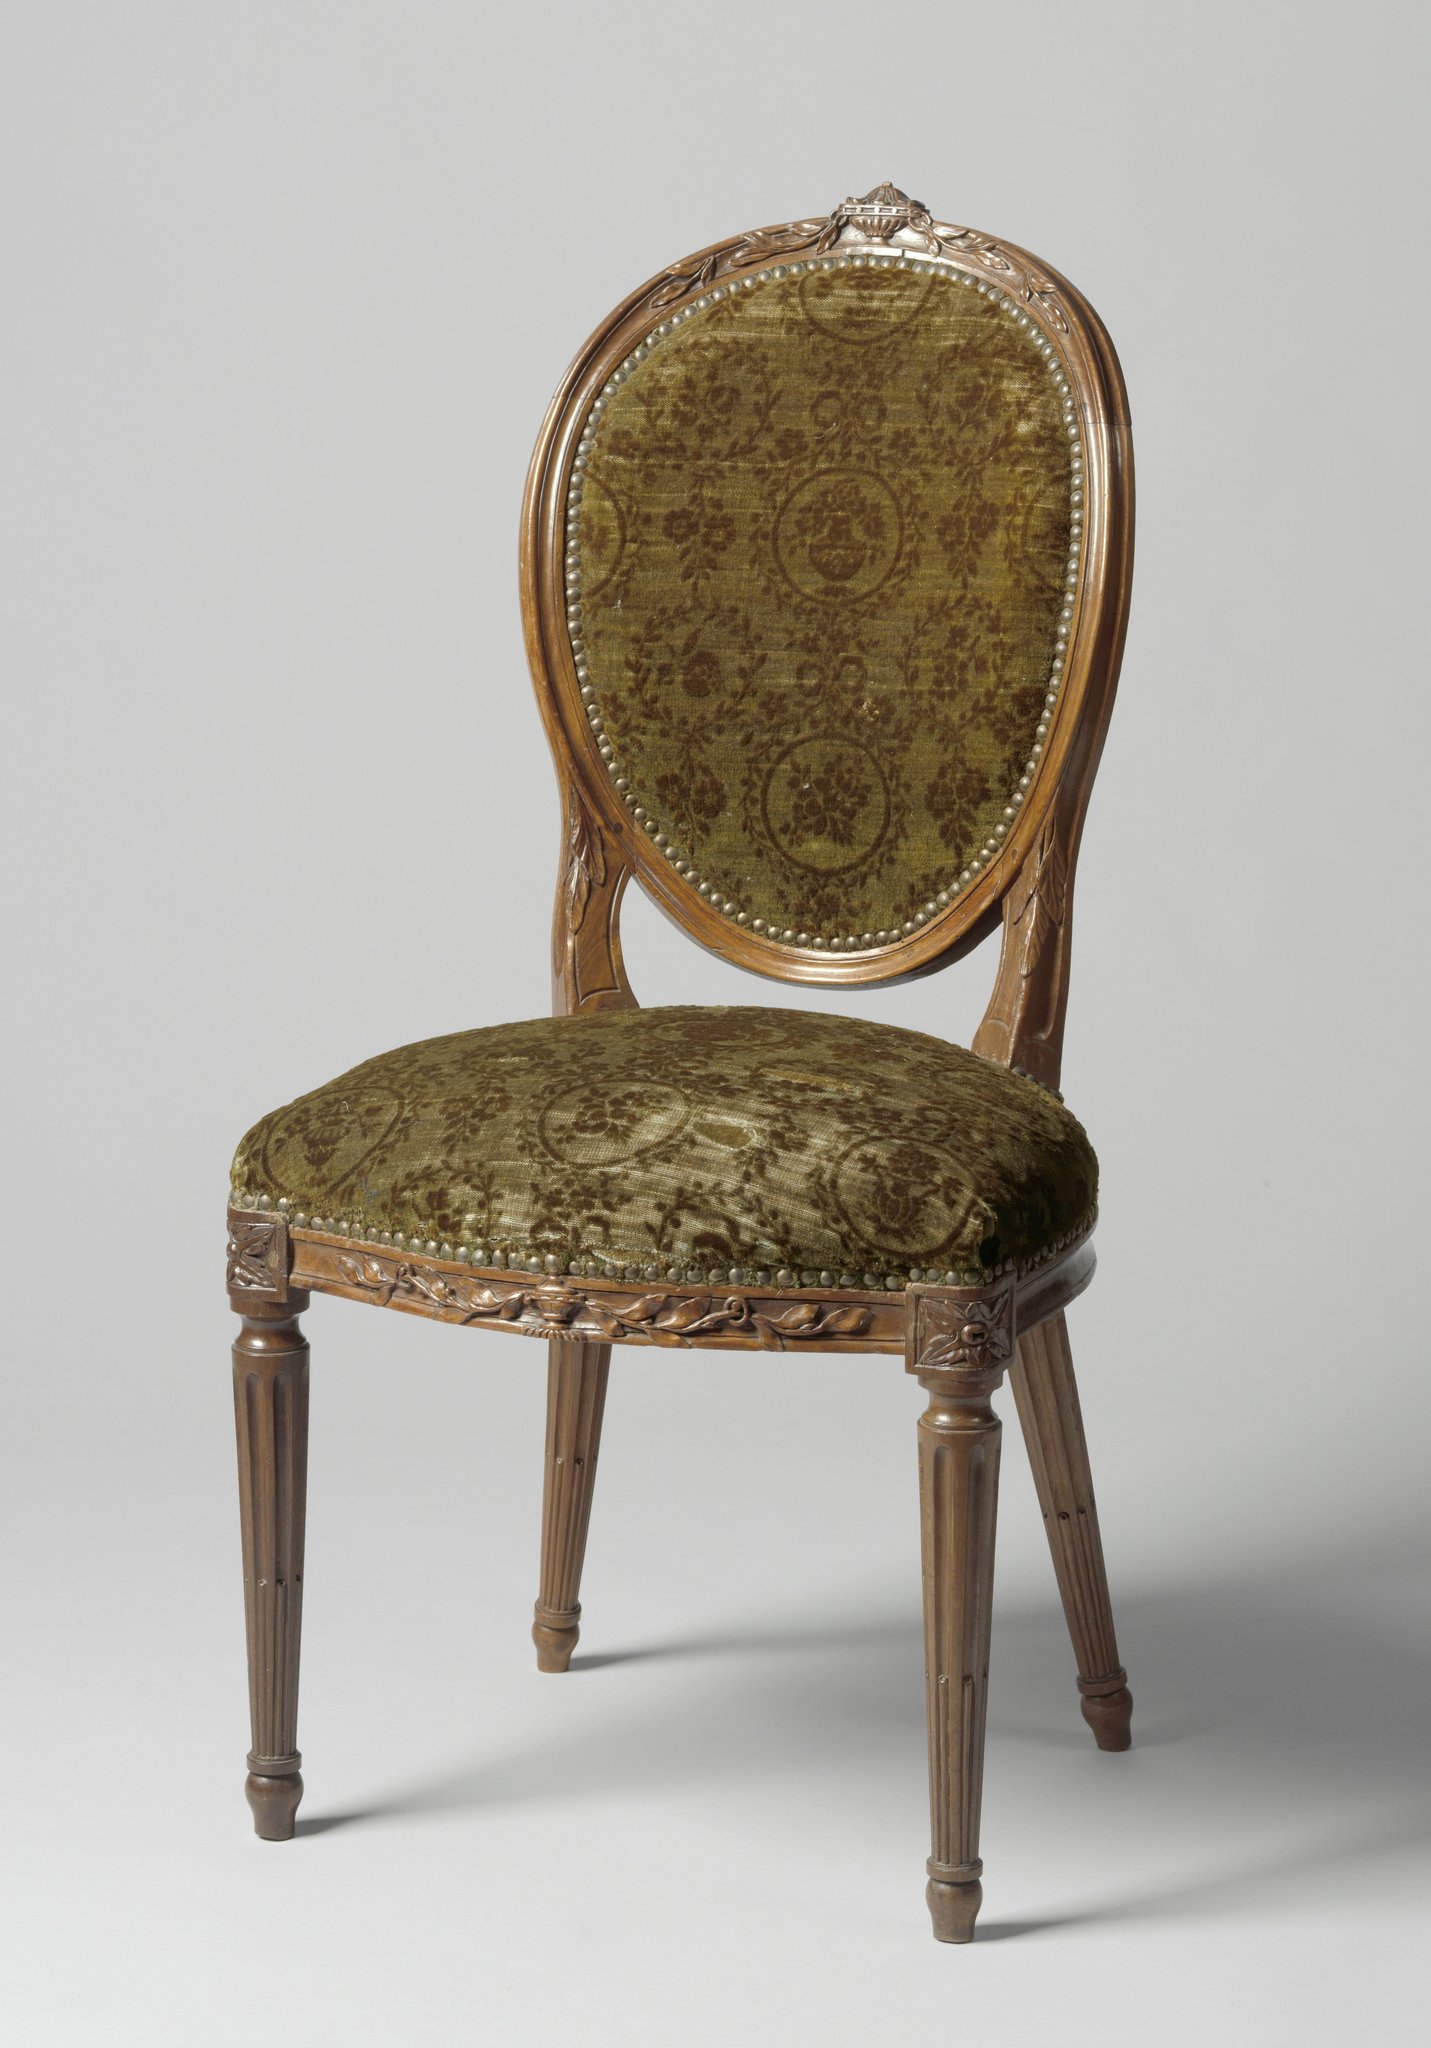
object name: chair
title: Stoel van mahoniehout, bekleed met groene trijp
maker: Anonymous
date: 1775-1800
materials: wood, textile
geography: netherlands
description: Armchair. Mahogany, the velvet upholstery has been renewed. Netherlands, c. 1780 - 1800. Given by Mr and Mrs Drucker-Fraser, 1922.